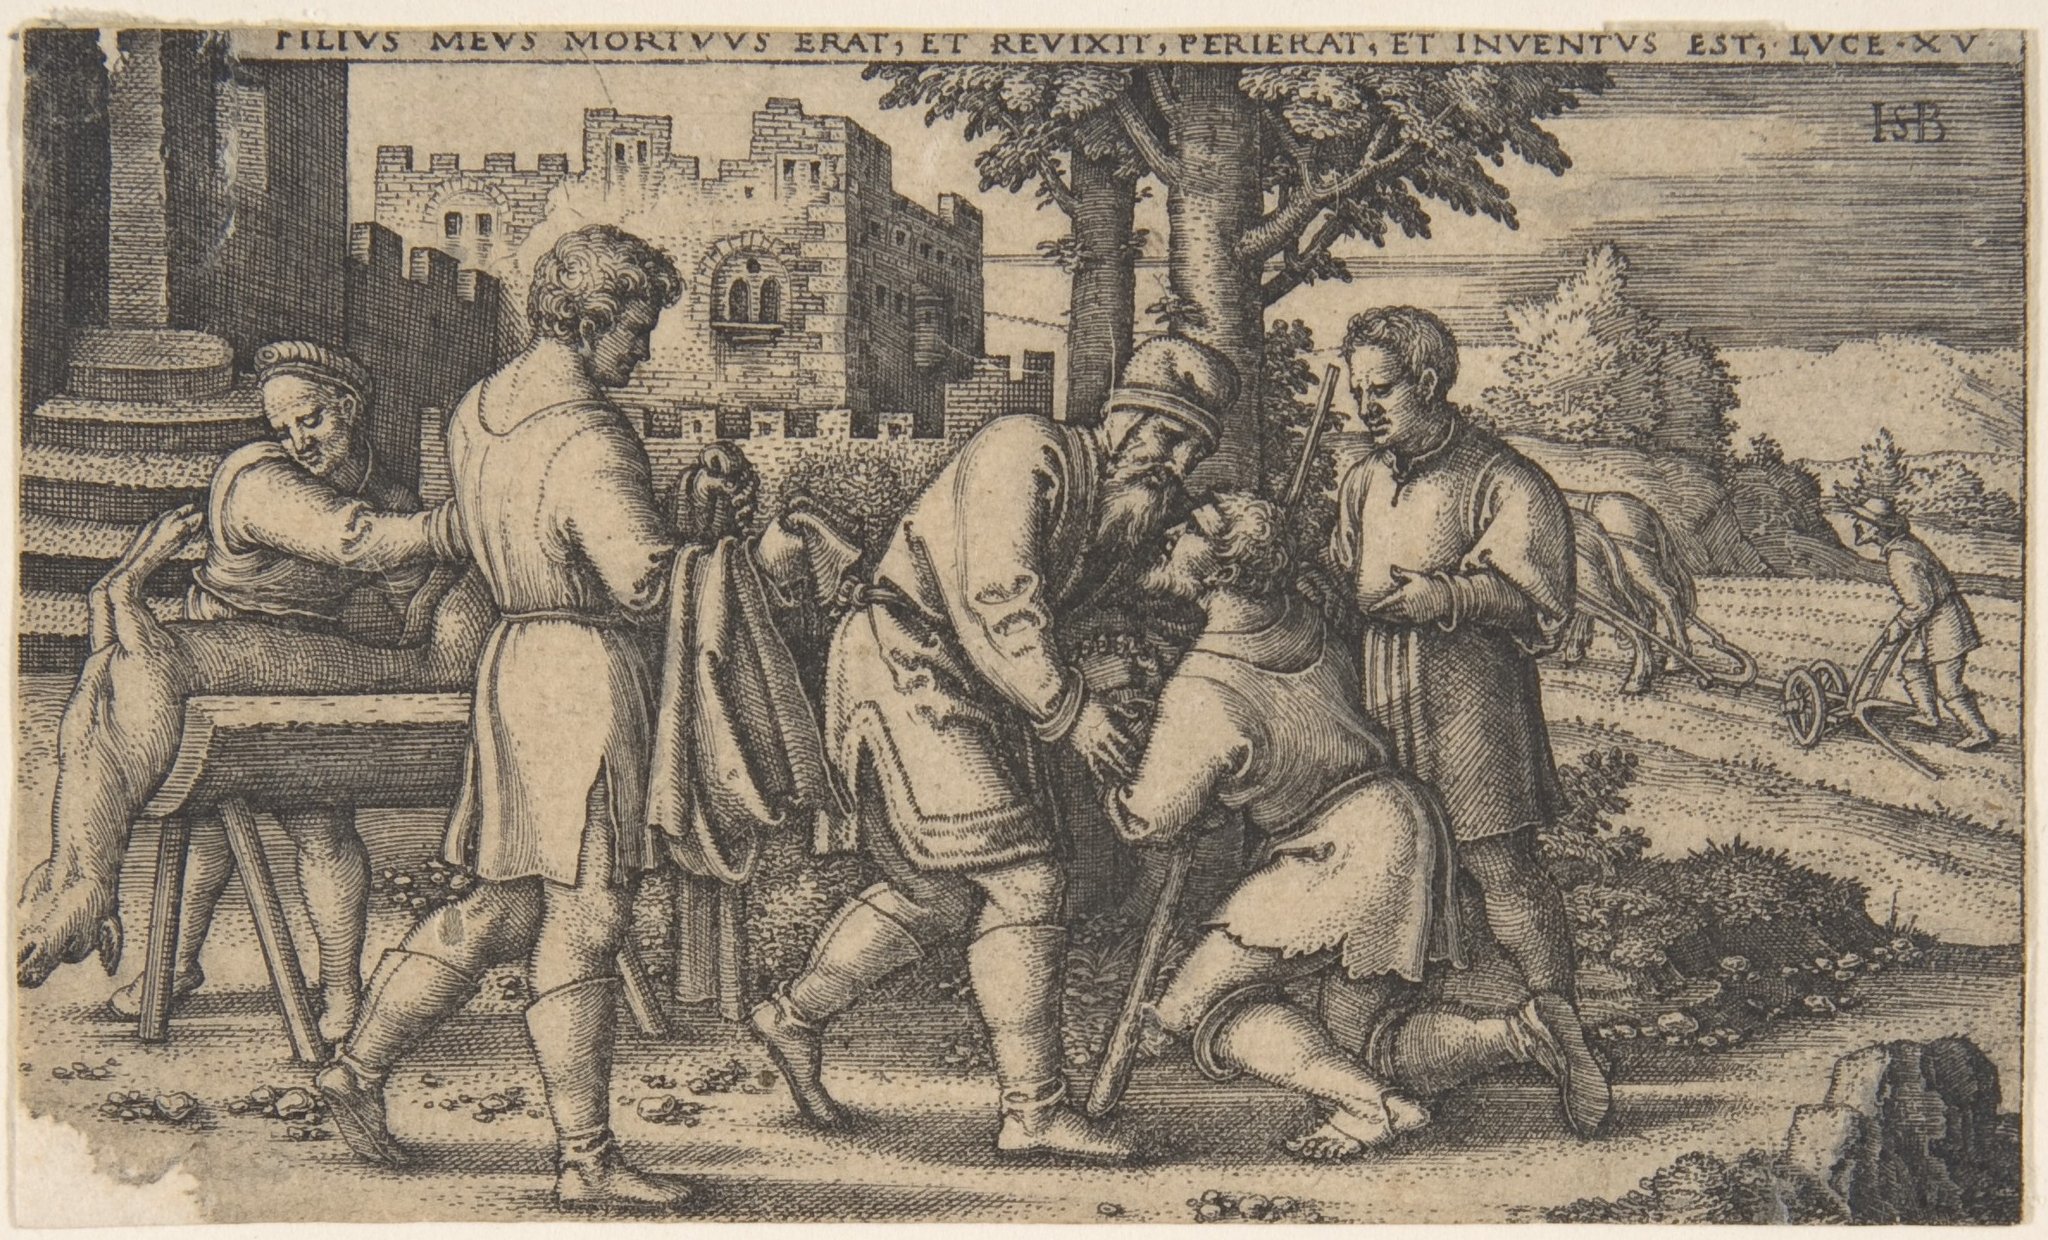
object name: print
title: Return of the Prodigal Son, from The History of the Prodigal Son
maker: sebald beham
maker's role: artist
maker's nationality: german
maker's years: 1500-1550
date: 1540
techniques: engraving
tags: buildings,men,trees,working